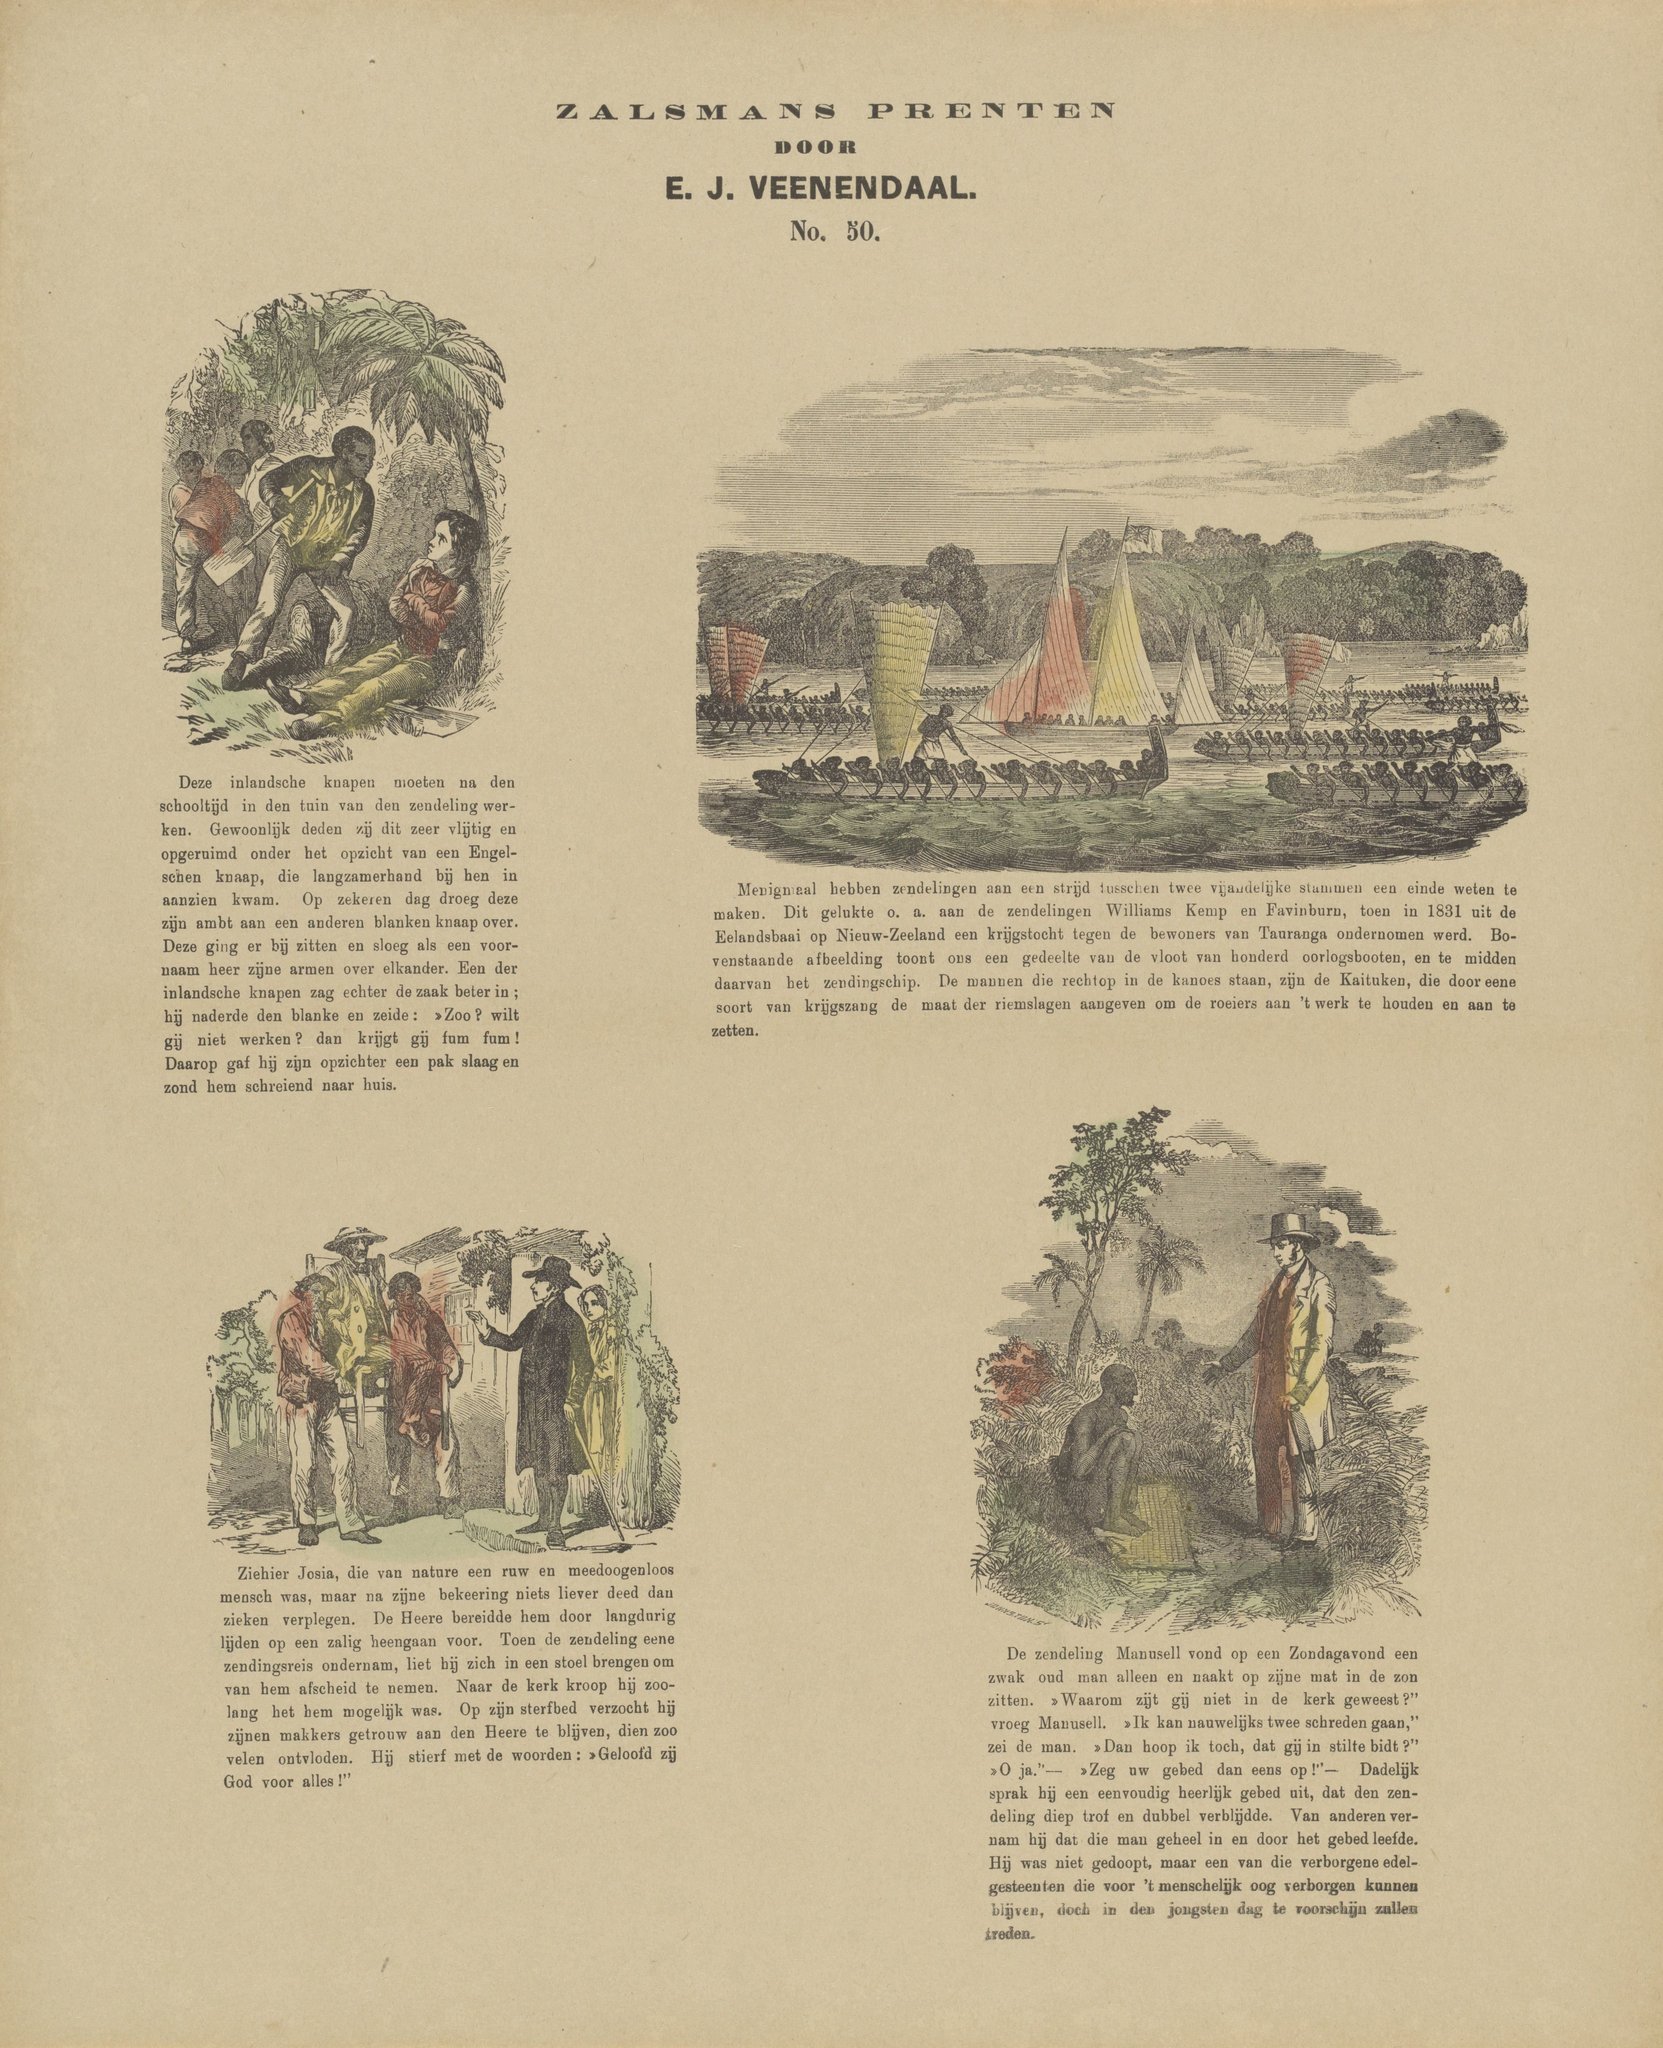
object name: print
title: Zalmans prenten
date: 1869-1882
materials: paper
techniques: colour, letterpress printing, engraving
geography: netherlands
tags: australian and oceanian races, new zealand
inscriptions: collector's mark: Lugt 2760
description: Blad met 4 voorstellingen van contact tussen Nieuw-Zeelanders en Europeanen. Onder elke afbeelding een onderschrift. Genummerd midden boven: No. 50.